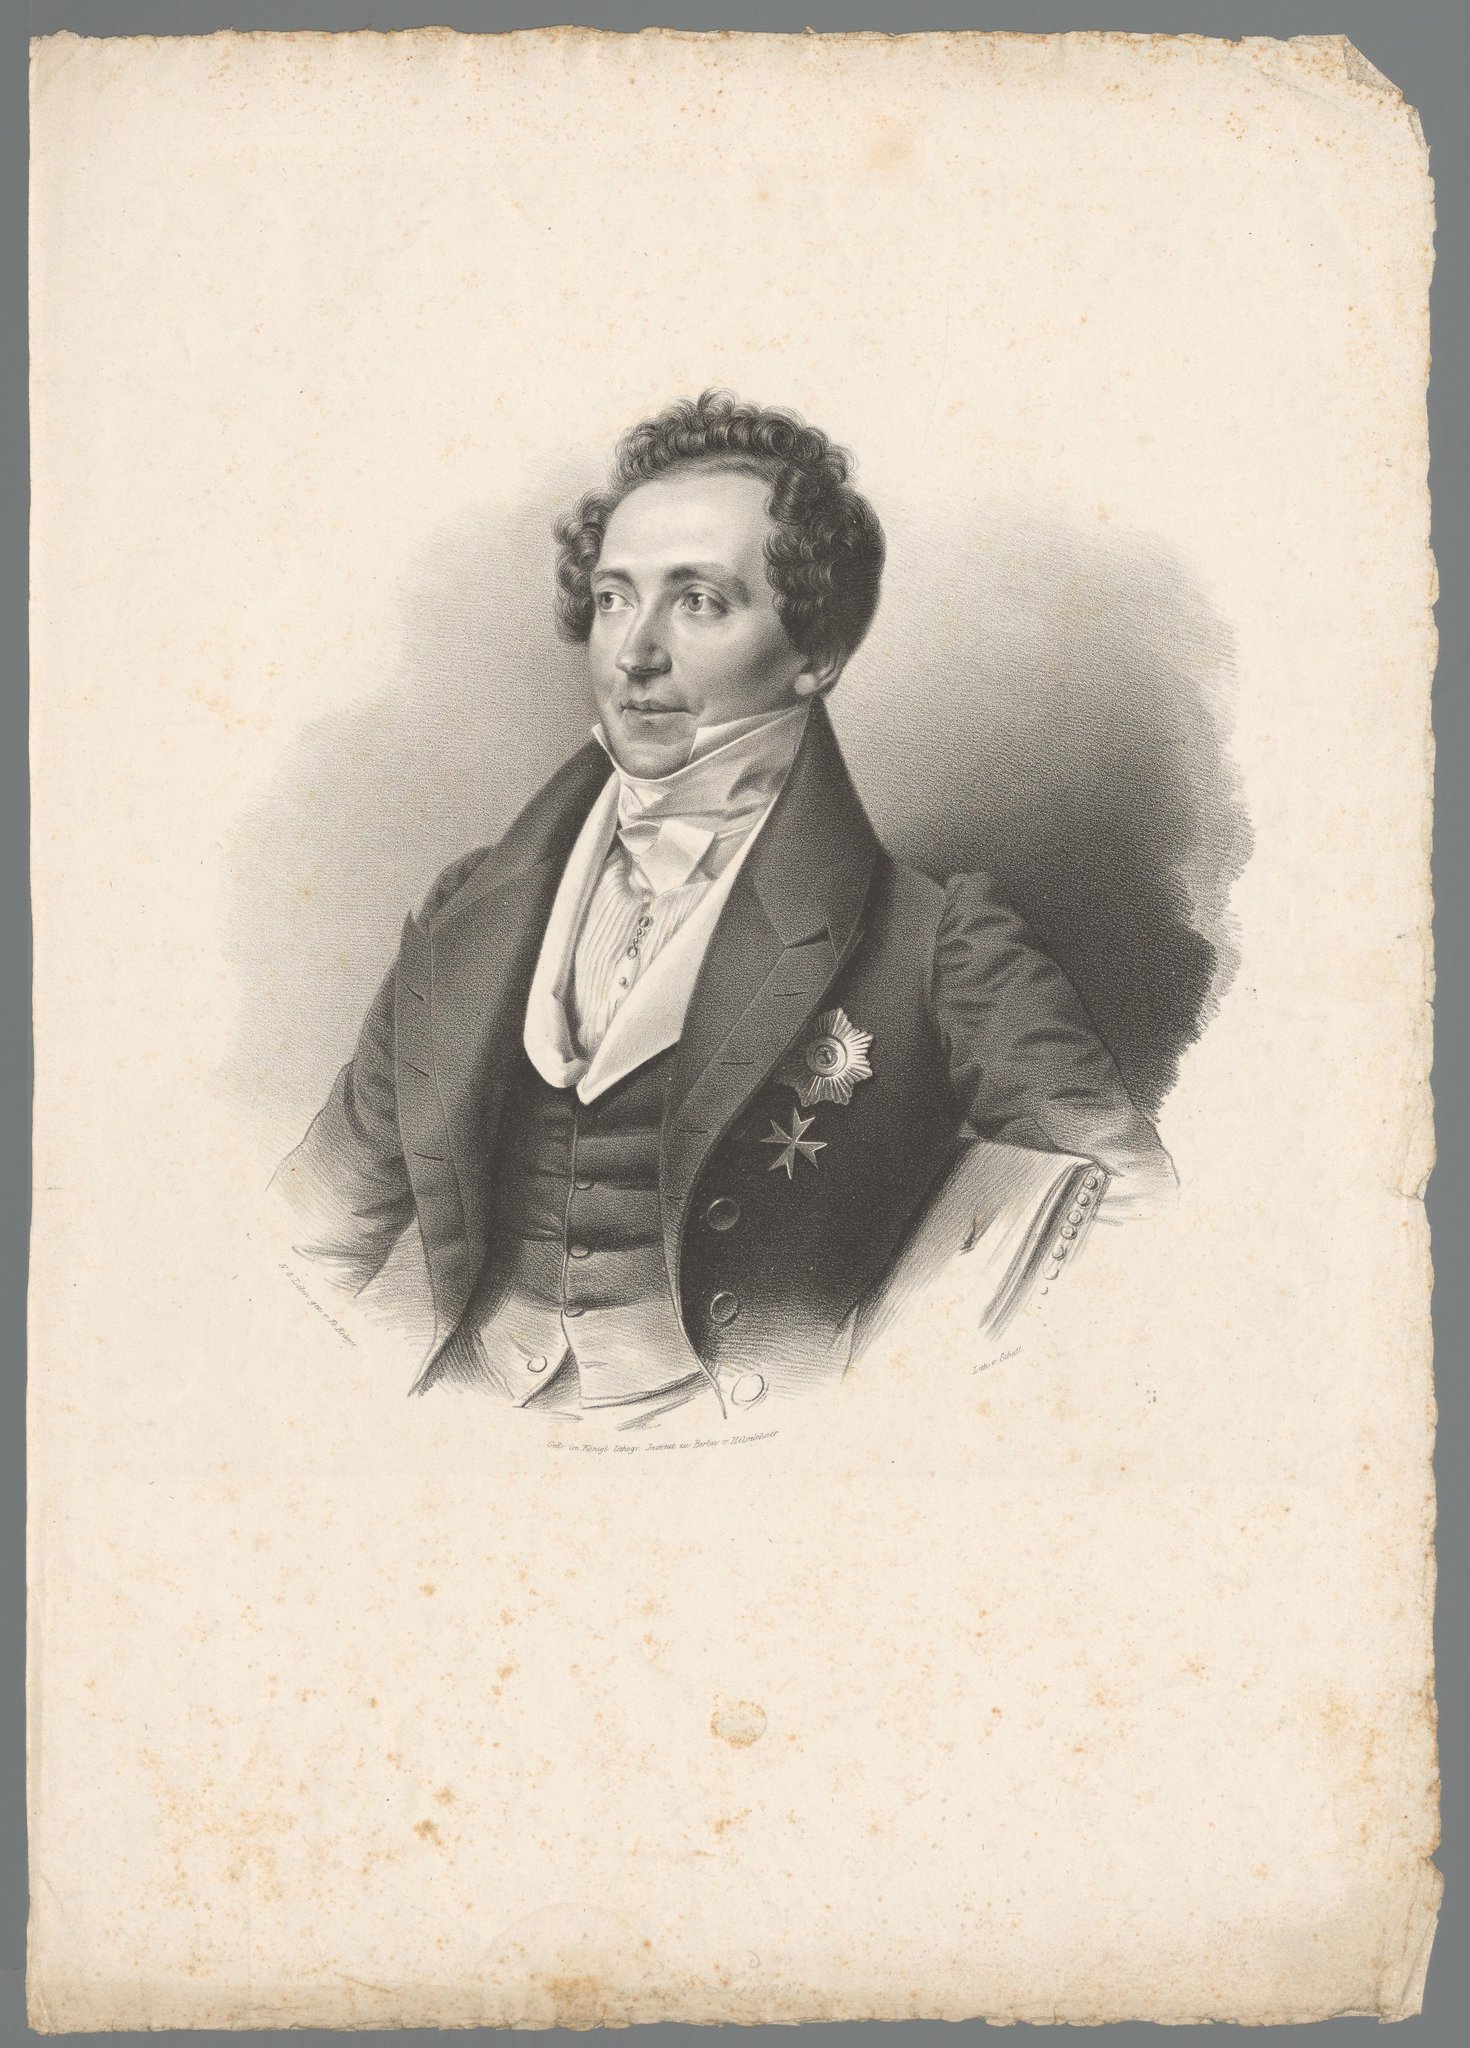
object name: print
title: Portret van Rochus Otto Manderup Heinrich zu Lynar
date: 1820-1865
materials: paper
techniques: lithograph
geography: berlin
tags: adult man, historical persons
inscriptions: collector's mark: Lugt 2228, check stamp: Lugt 4519